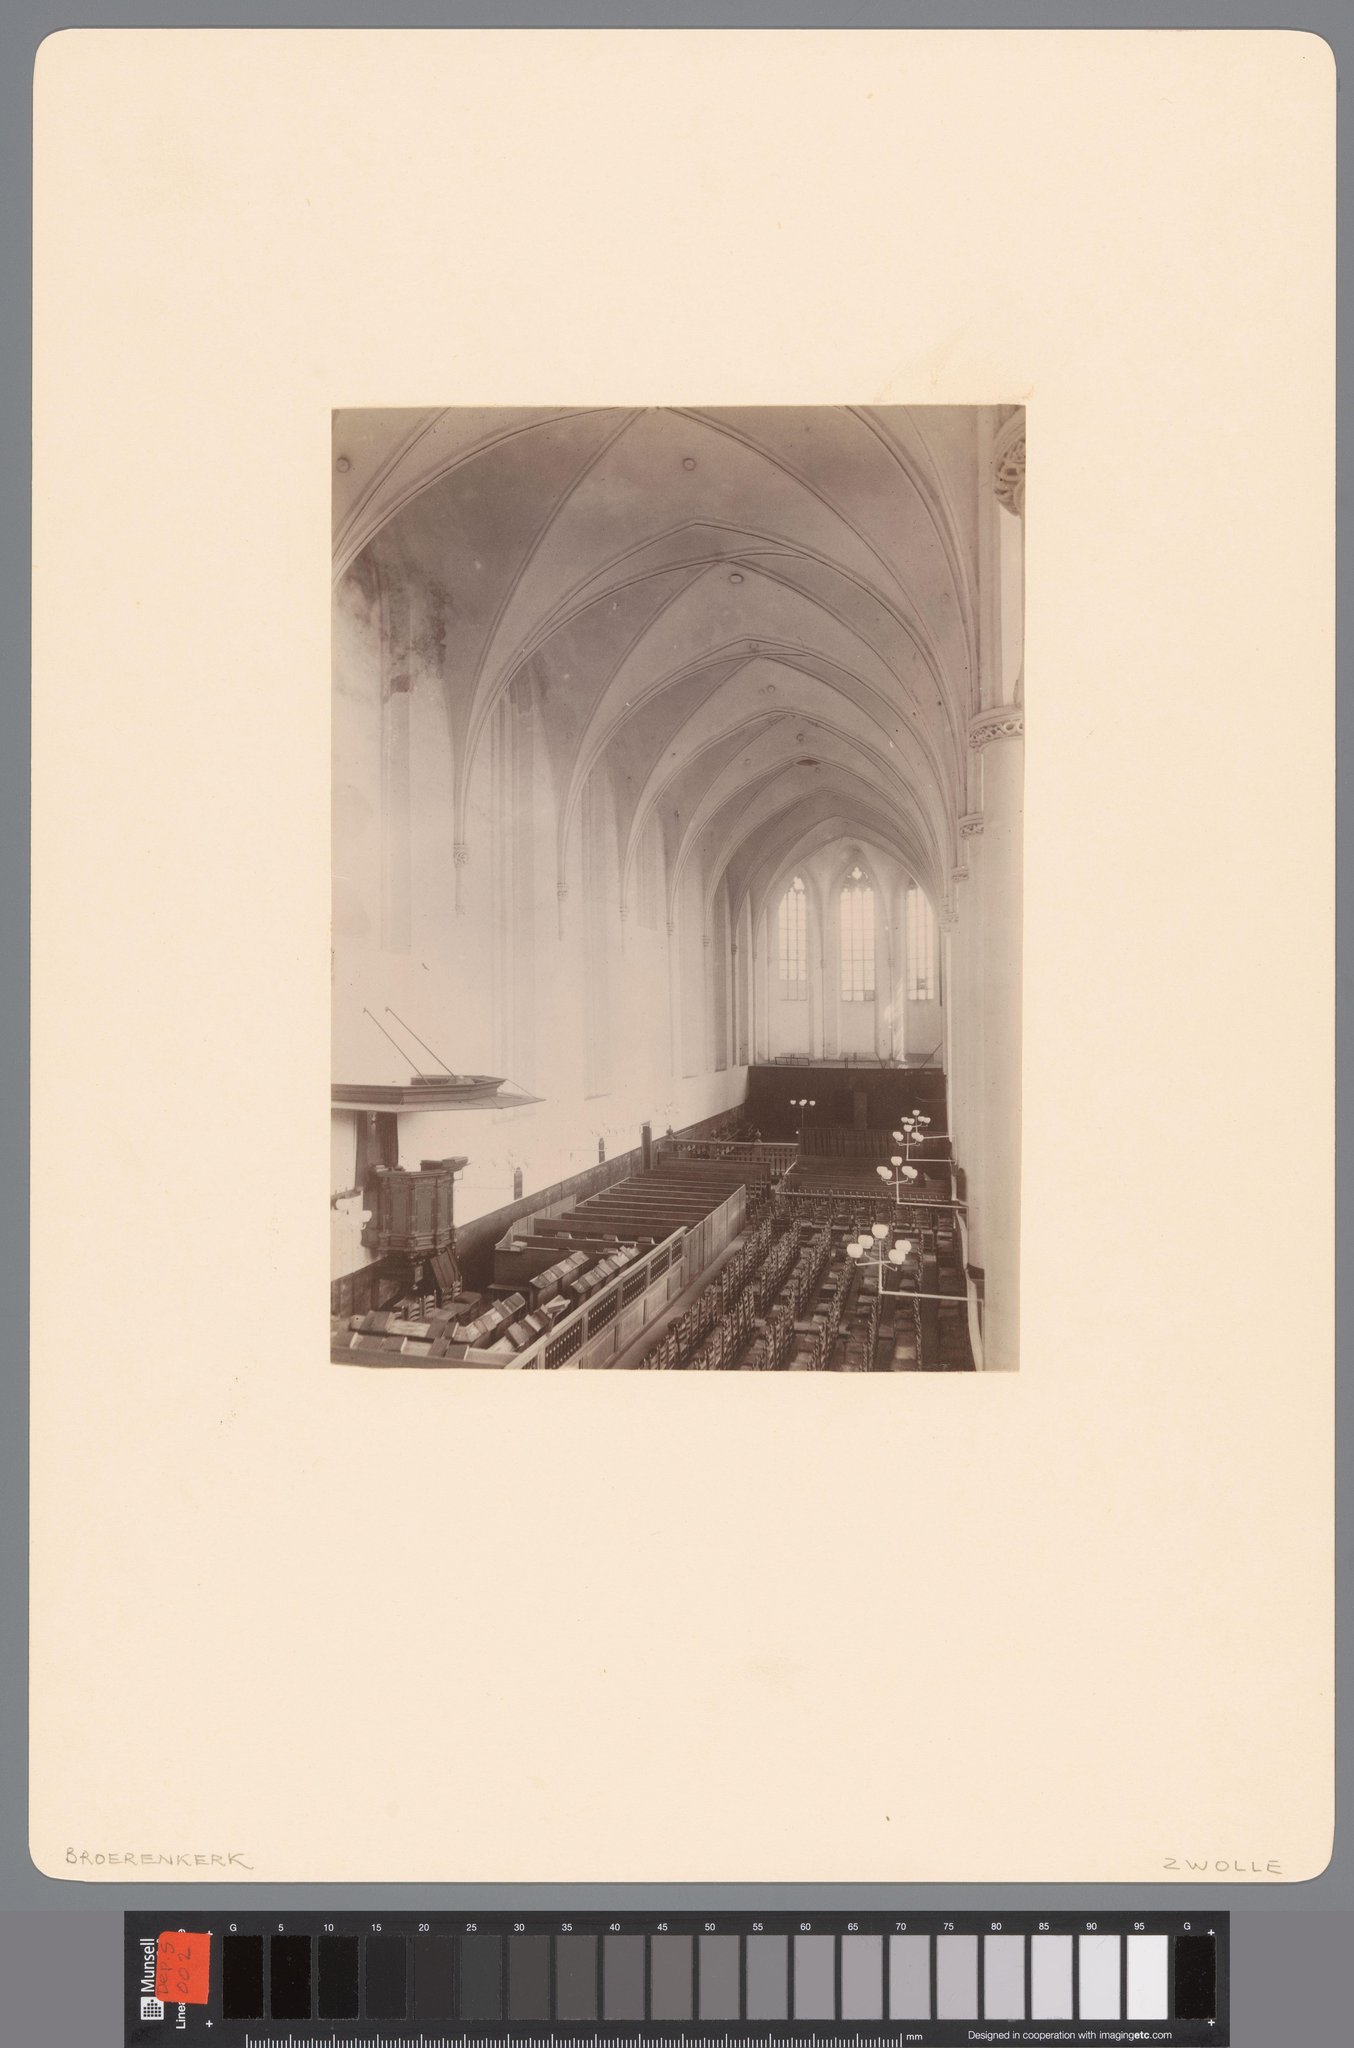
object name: photograph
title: Interieur van de Broerenkerk te Zwolle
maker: anoniem (monumentenzorg)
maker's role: fotograaf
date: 1909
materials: cardboard, photographic support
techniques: albumen print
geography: broerenkerk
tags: interior of church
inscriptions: annotation: ‘Broerenkerk/ Zwolle’, annotation: ‘Broerenkerk te Zwolle/ Interieur gezien naar het koor. juni 1909’